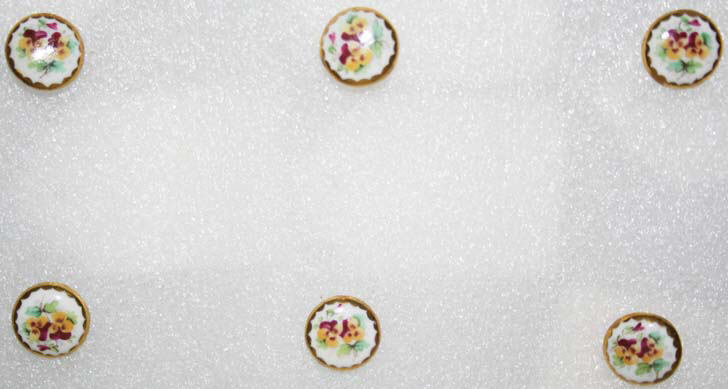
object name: button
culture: european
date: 1900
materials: porcelain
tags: flowers